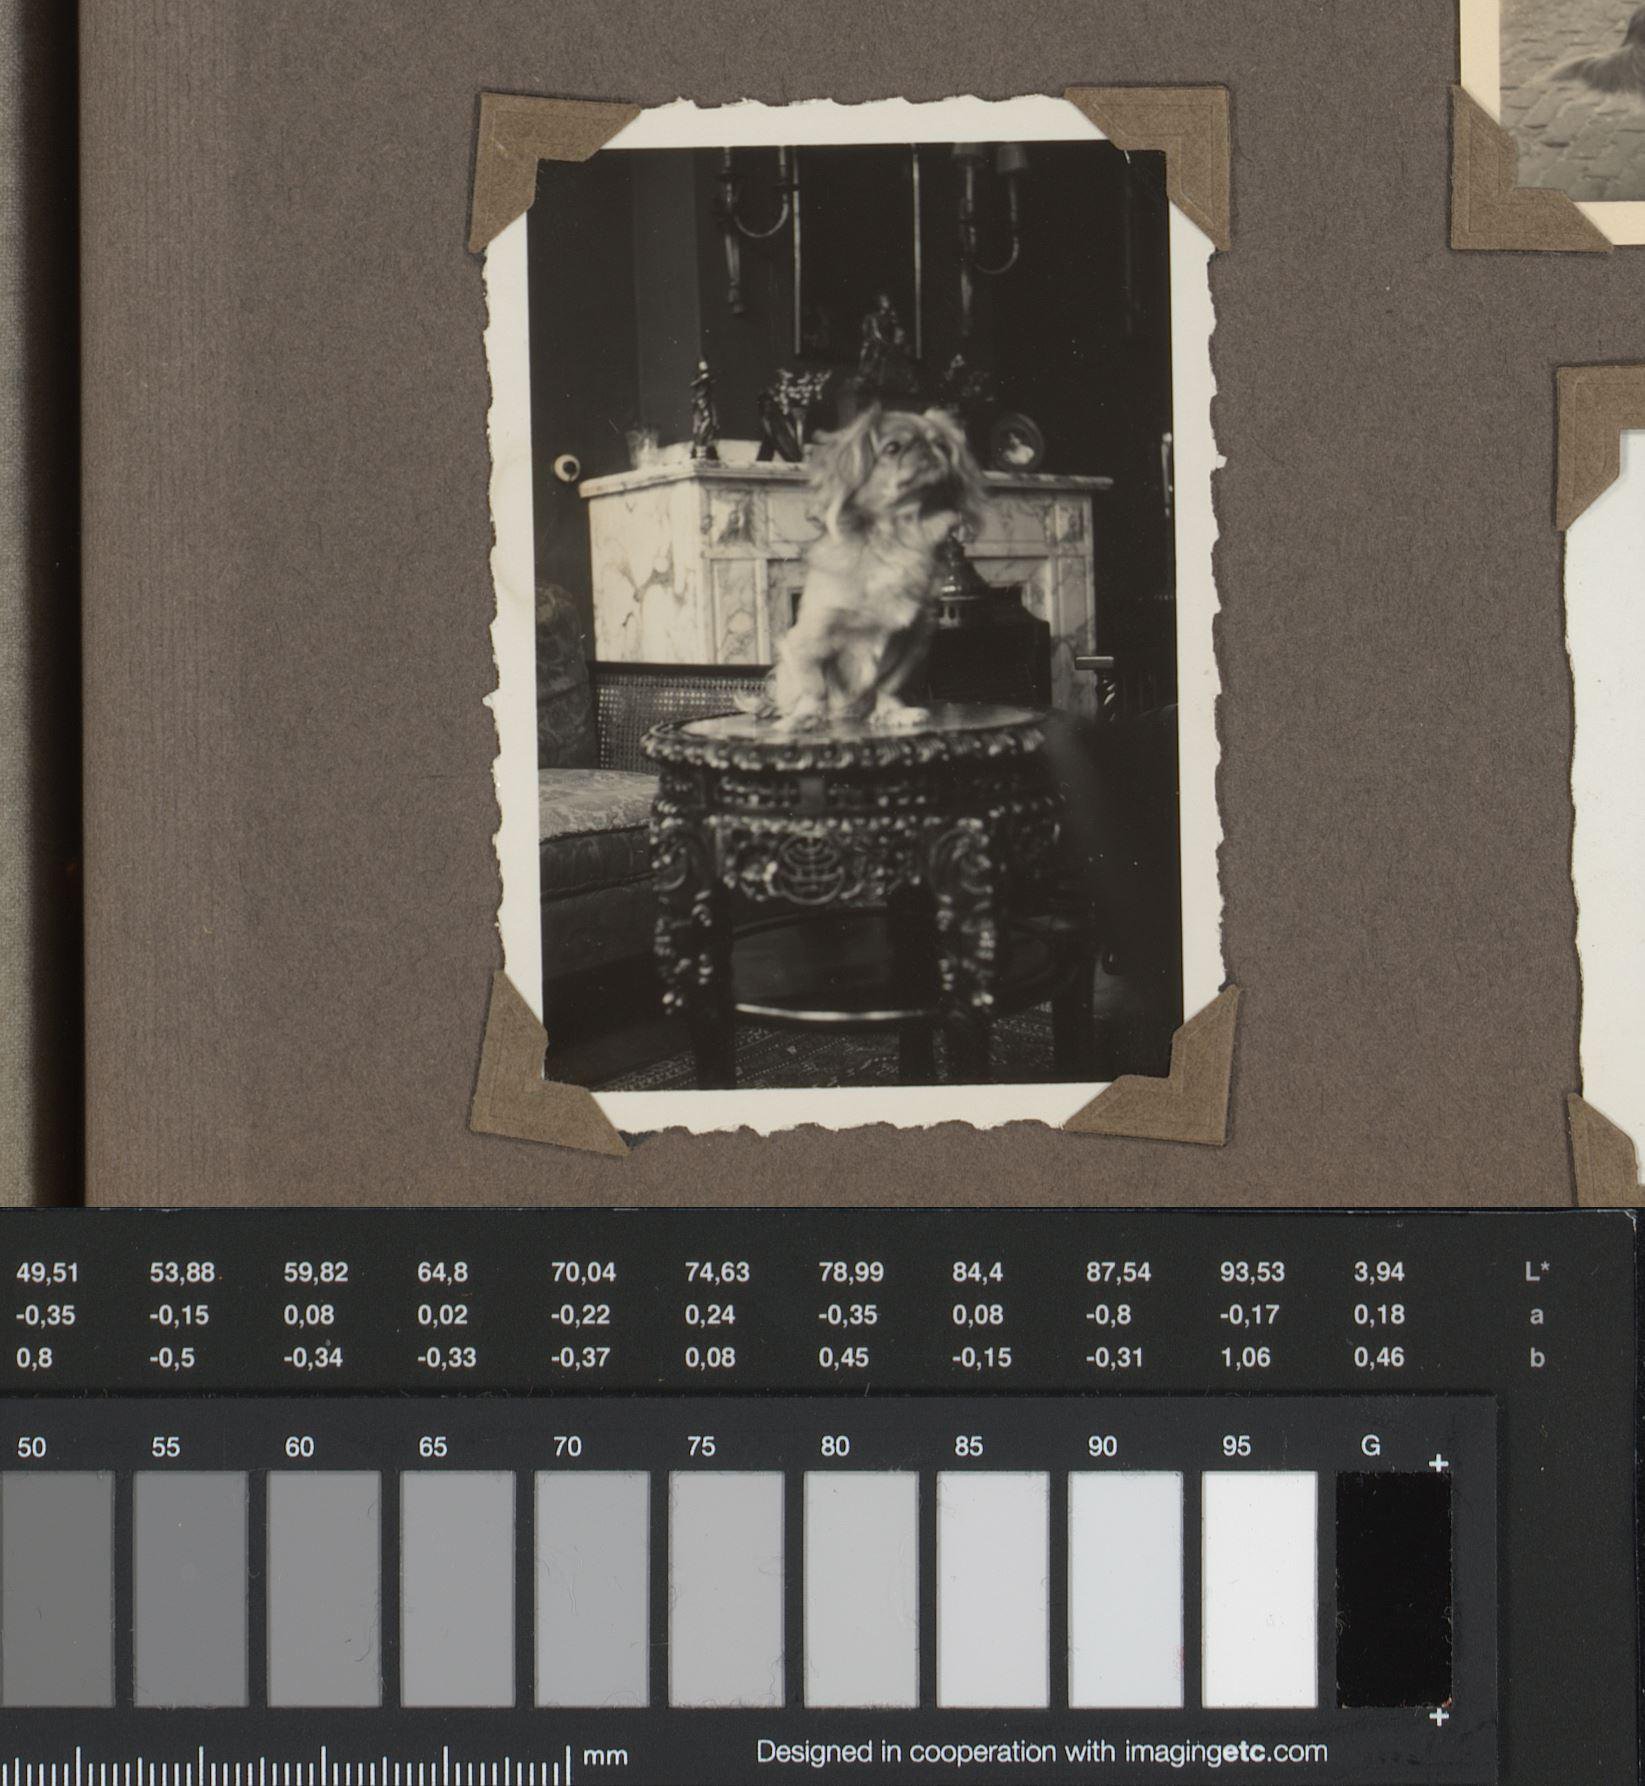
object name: album leaf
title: Pekinees zittend op een bijzettafel in een interieur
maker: Anonymous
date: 1930-1935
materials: paper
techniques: gelatin silver print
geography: netherlands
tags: dog, netherlands